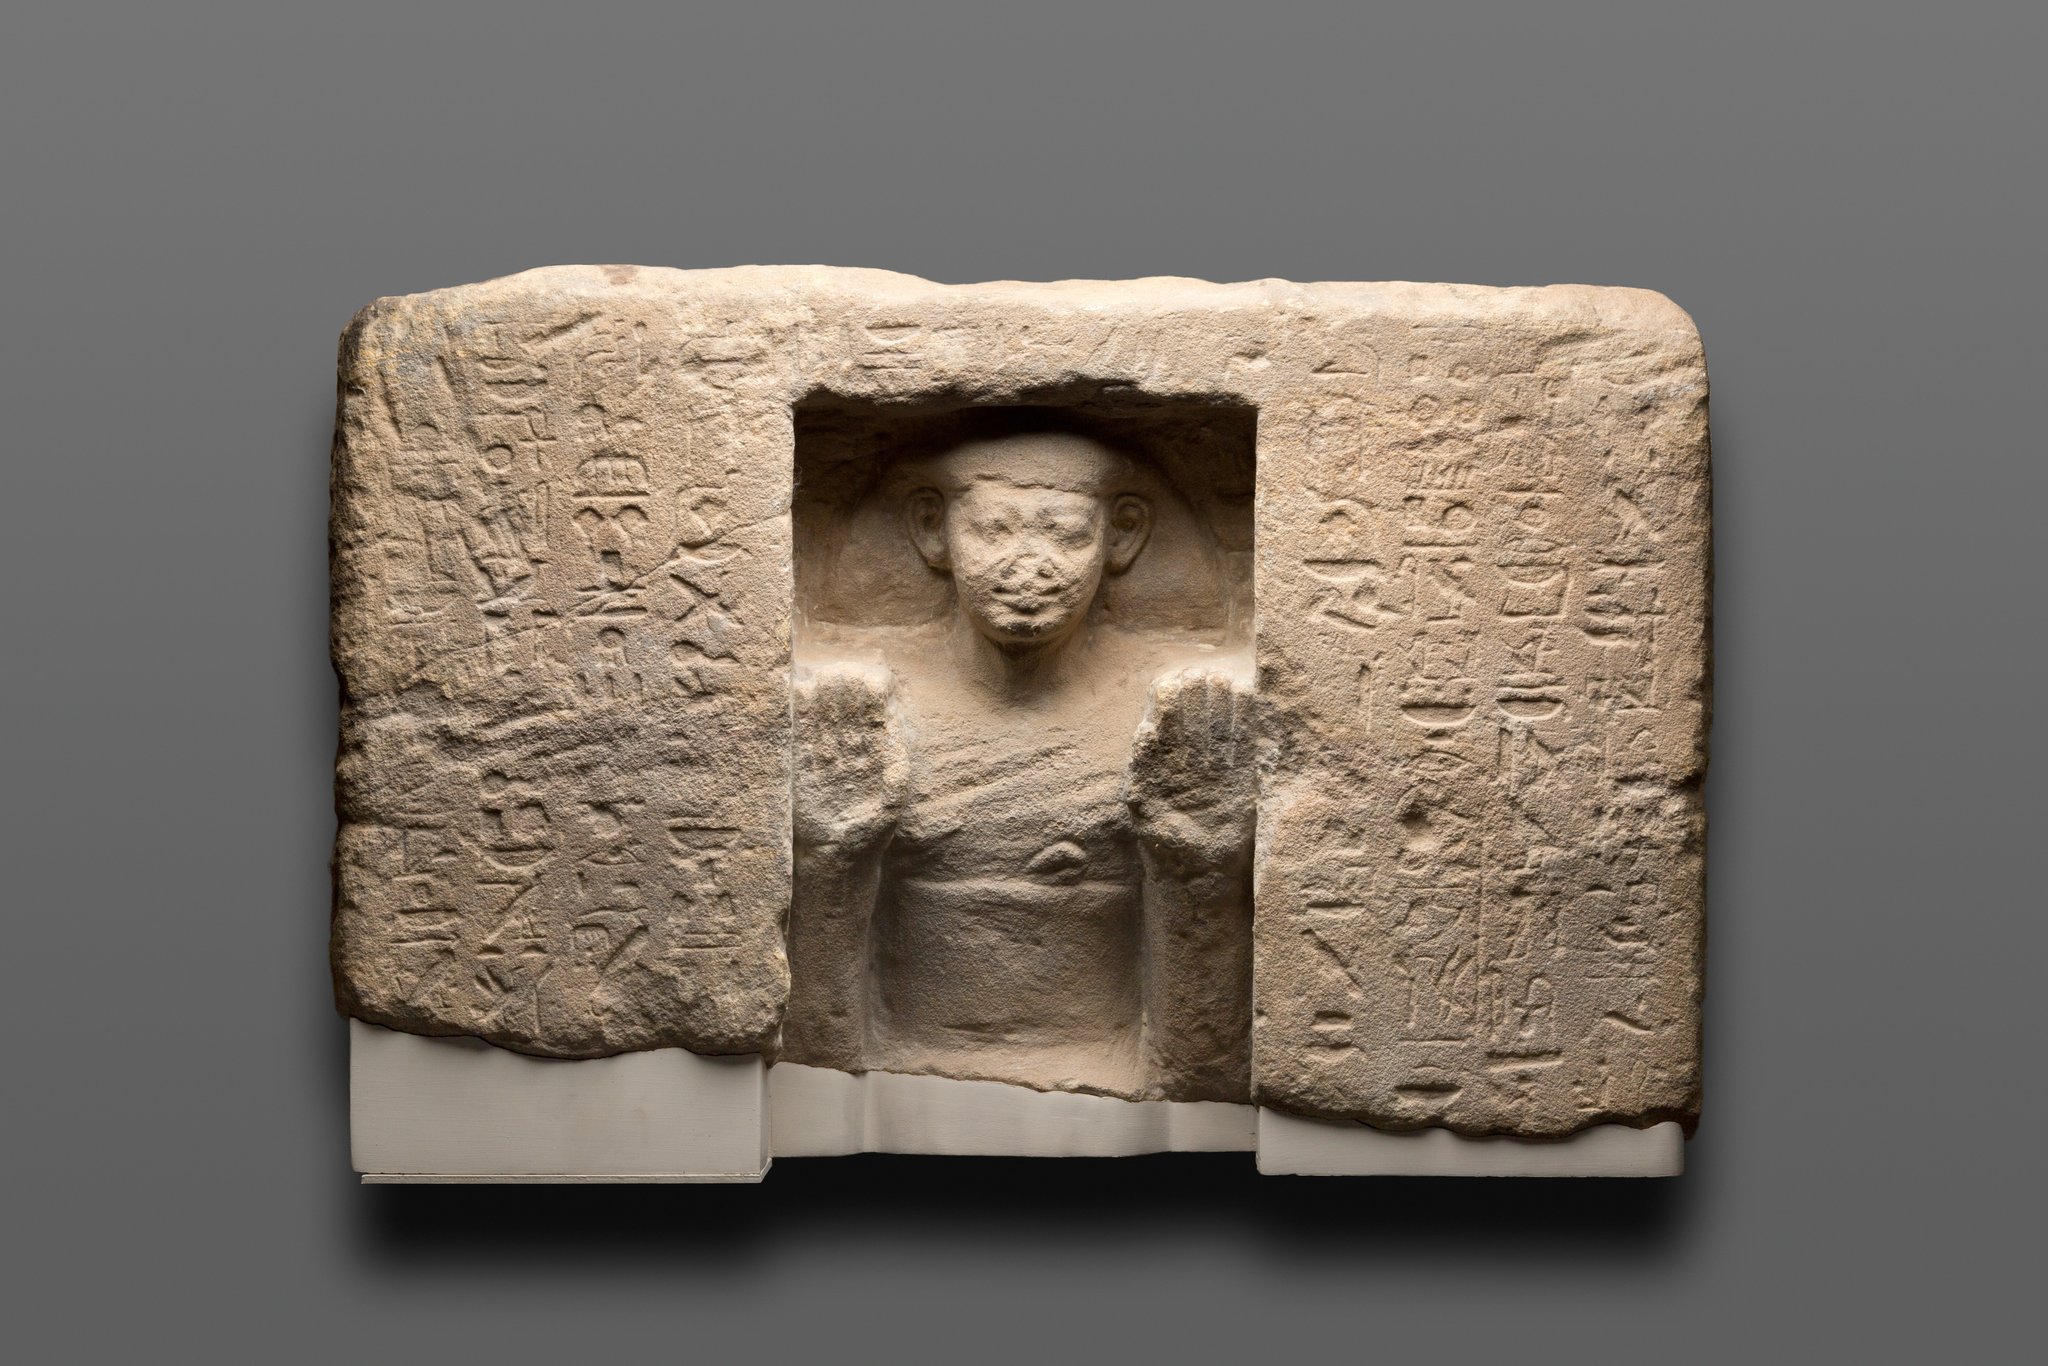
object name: false door, niche stela, solar hymn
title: Niche Stela with Nebseny Reciting Solar Hymns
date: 1550-1400 BCE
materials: stone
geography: egypt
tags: men,hieroglyphs